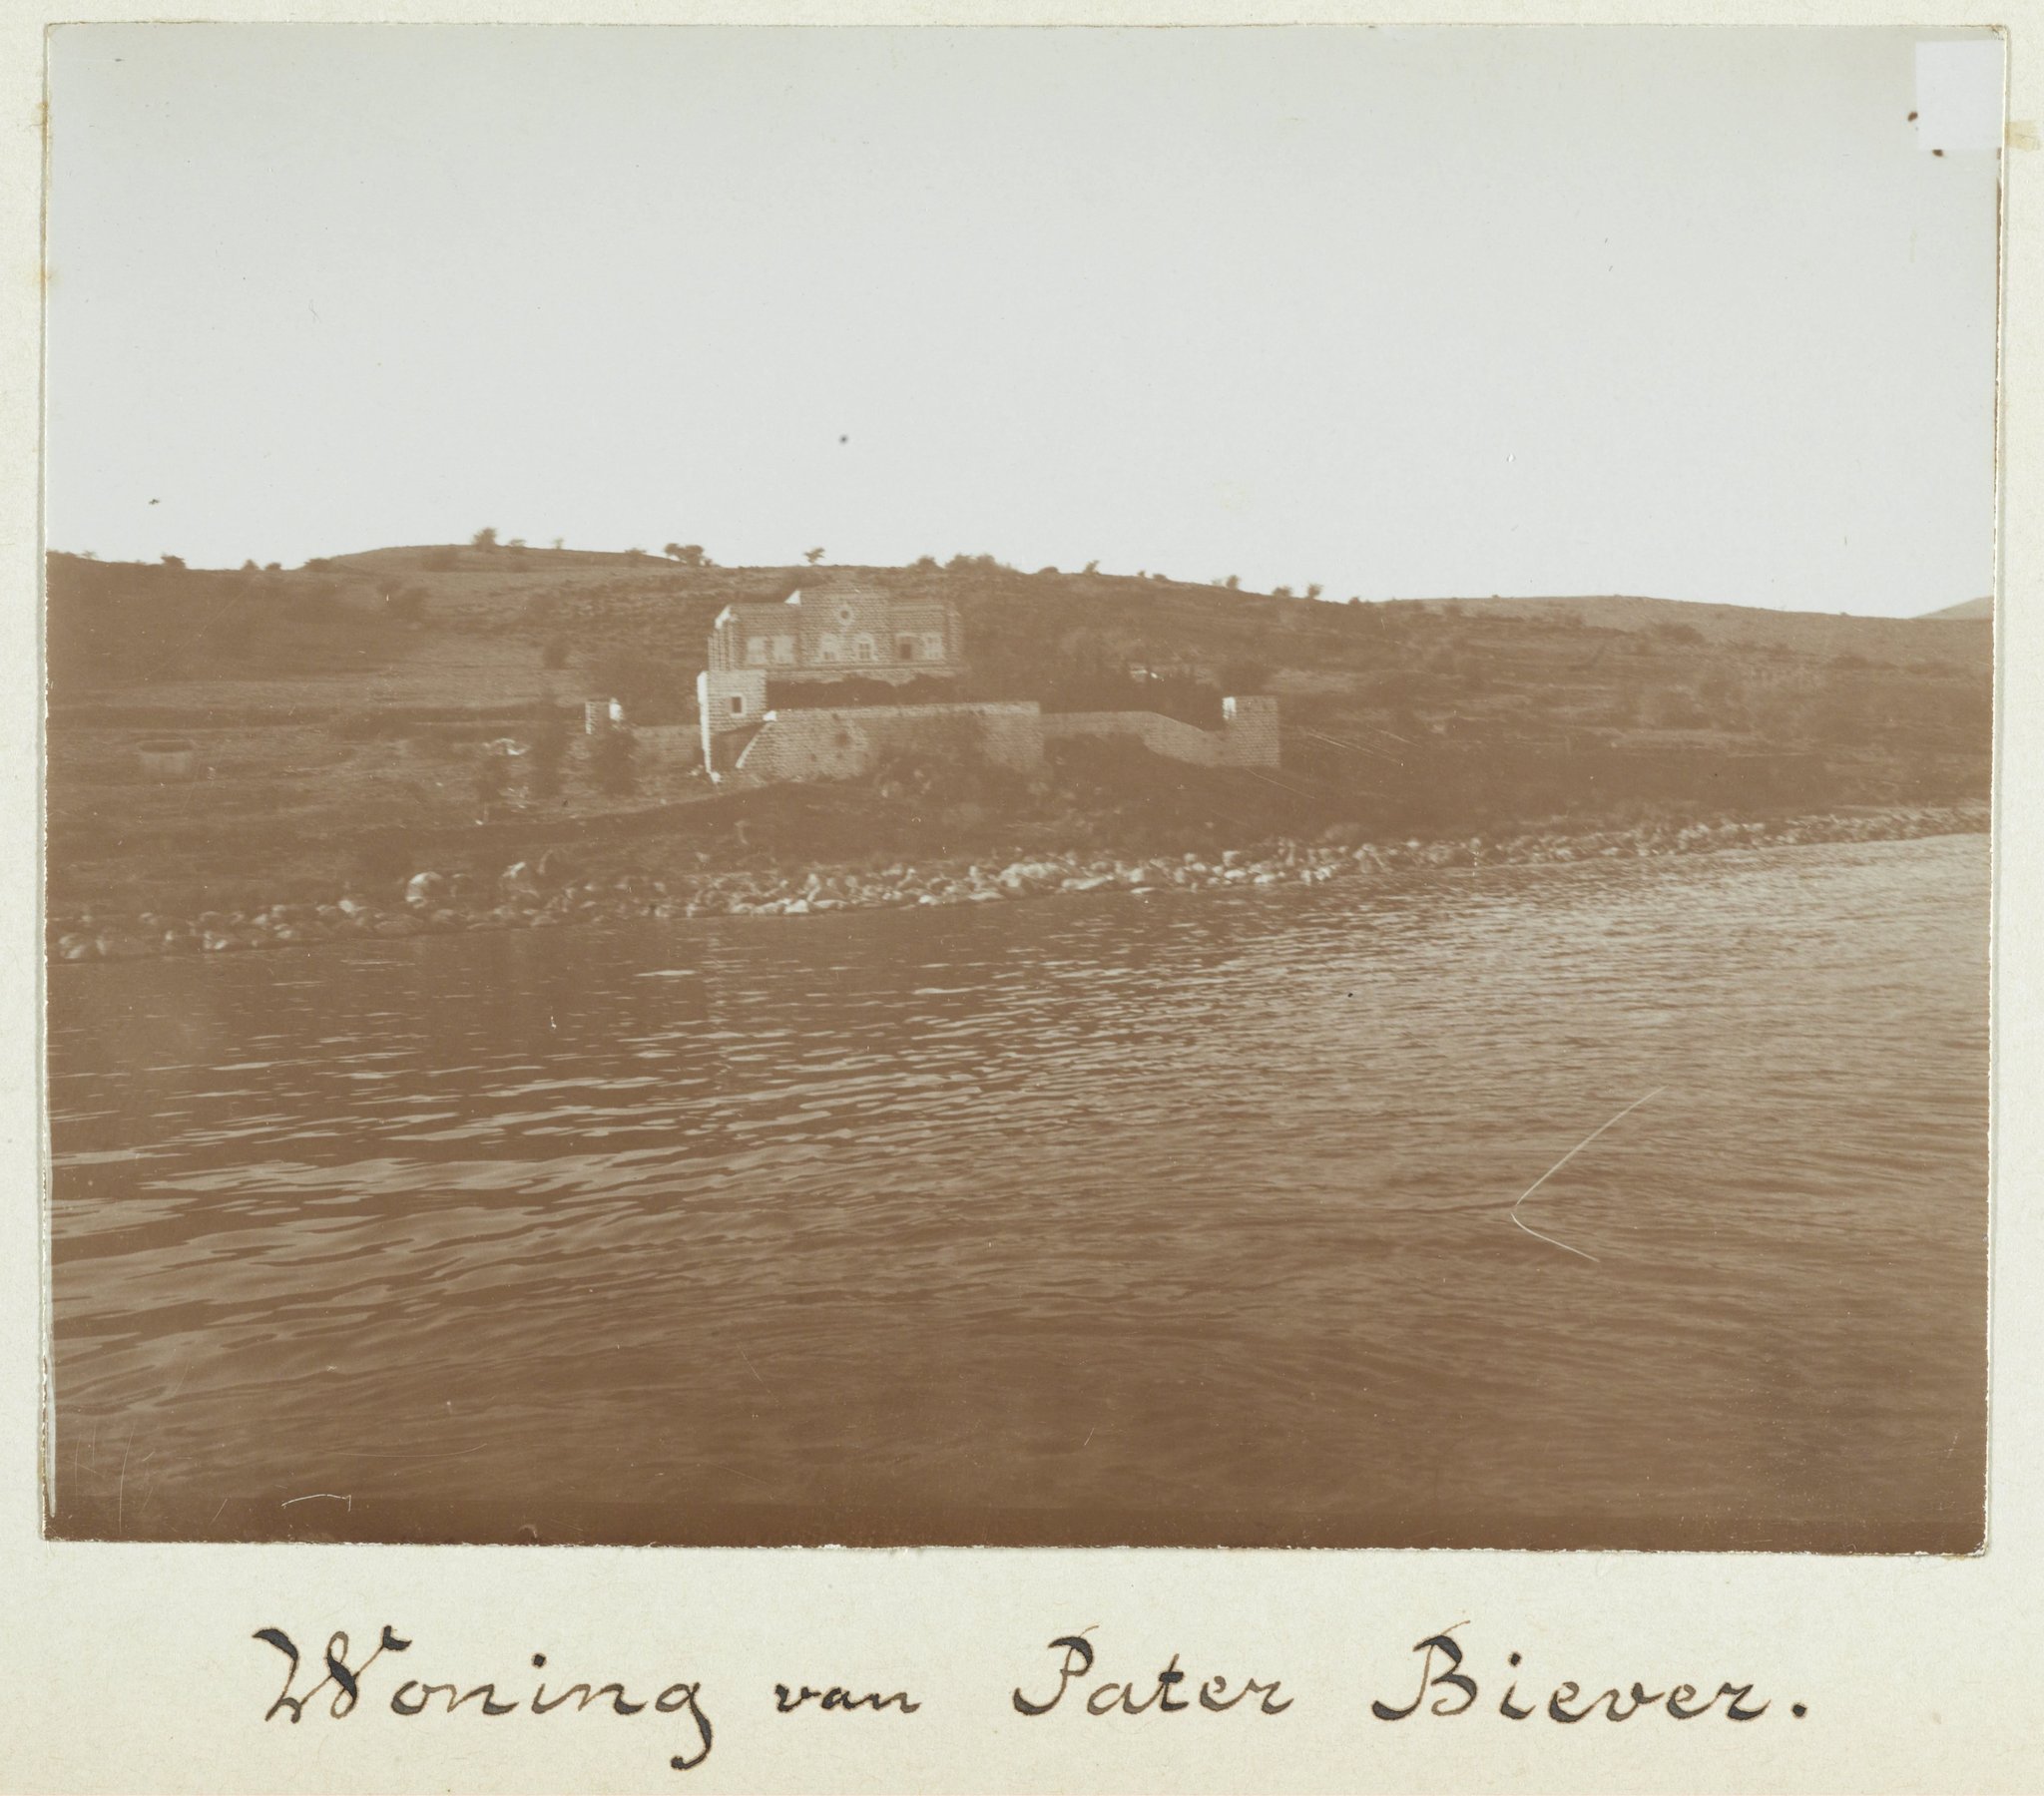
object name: photograph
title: Gezicht op de woning van pater Théodore Zephyrin Biever in Tabgha aan het meer van Tiberias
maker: johannes lodewijk heldring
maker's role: fotograaf, predikant, schrijver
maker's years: 1852-1923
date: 1898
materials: paper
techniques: collodion silver print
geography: israel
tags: clergyman, lake, civic architecture; edifices; dwellings